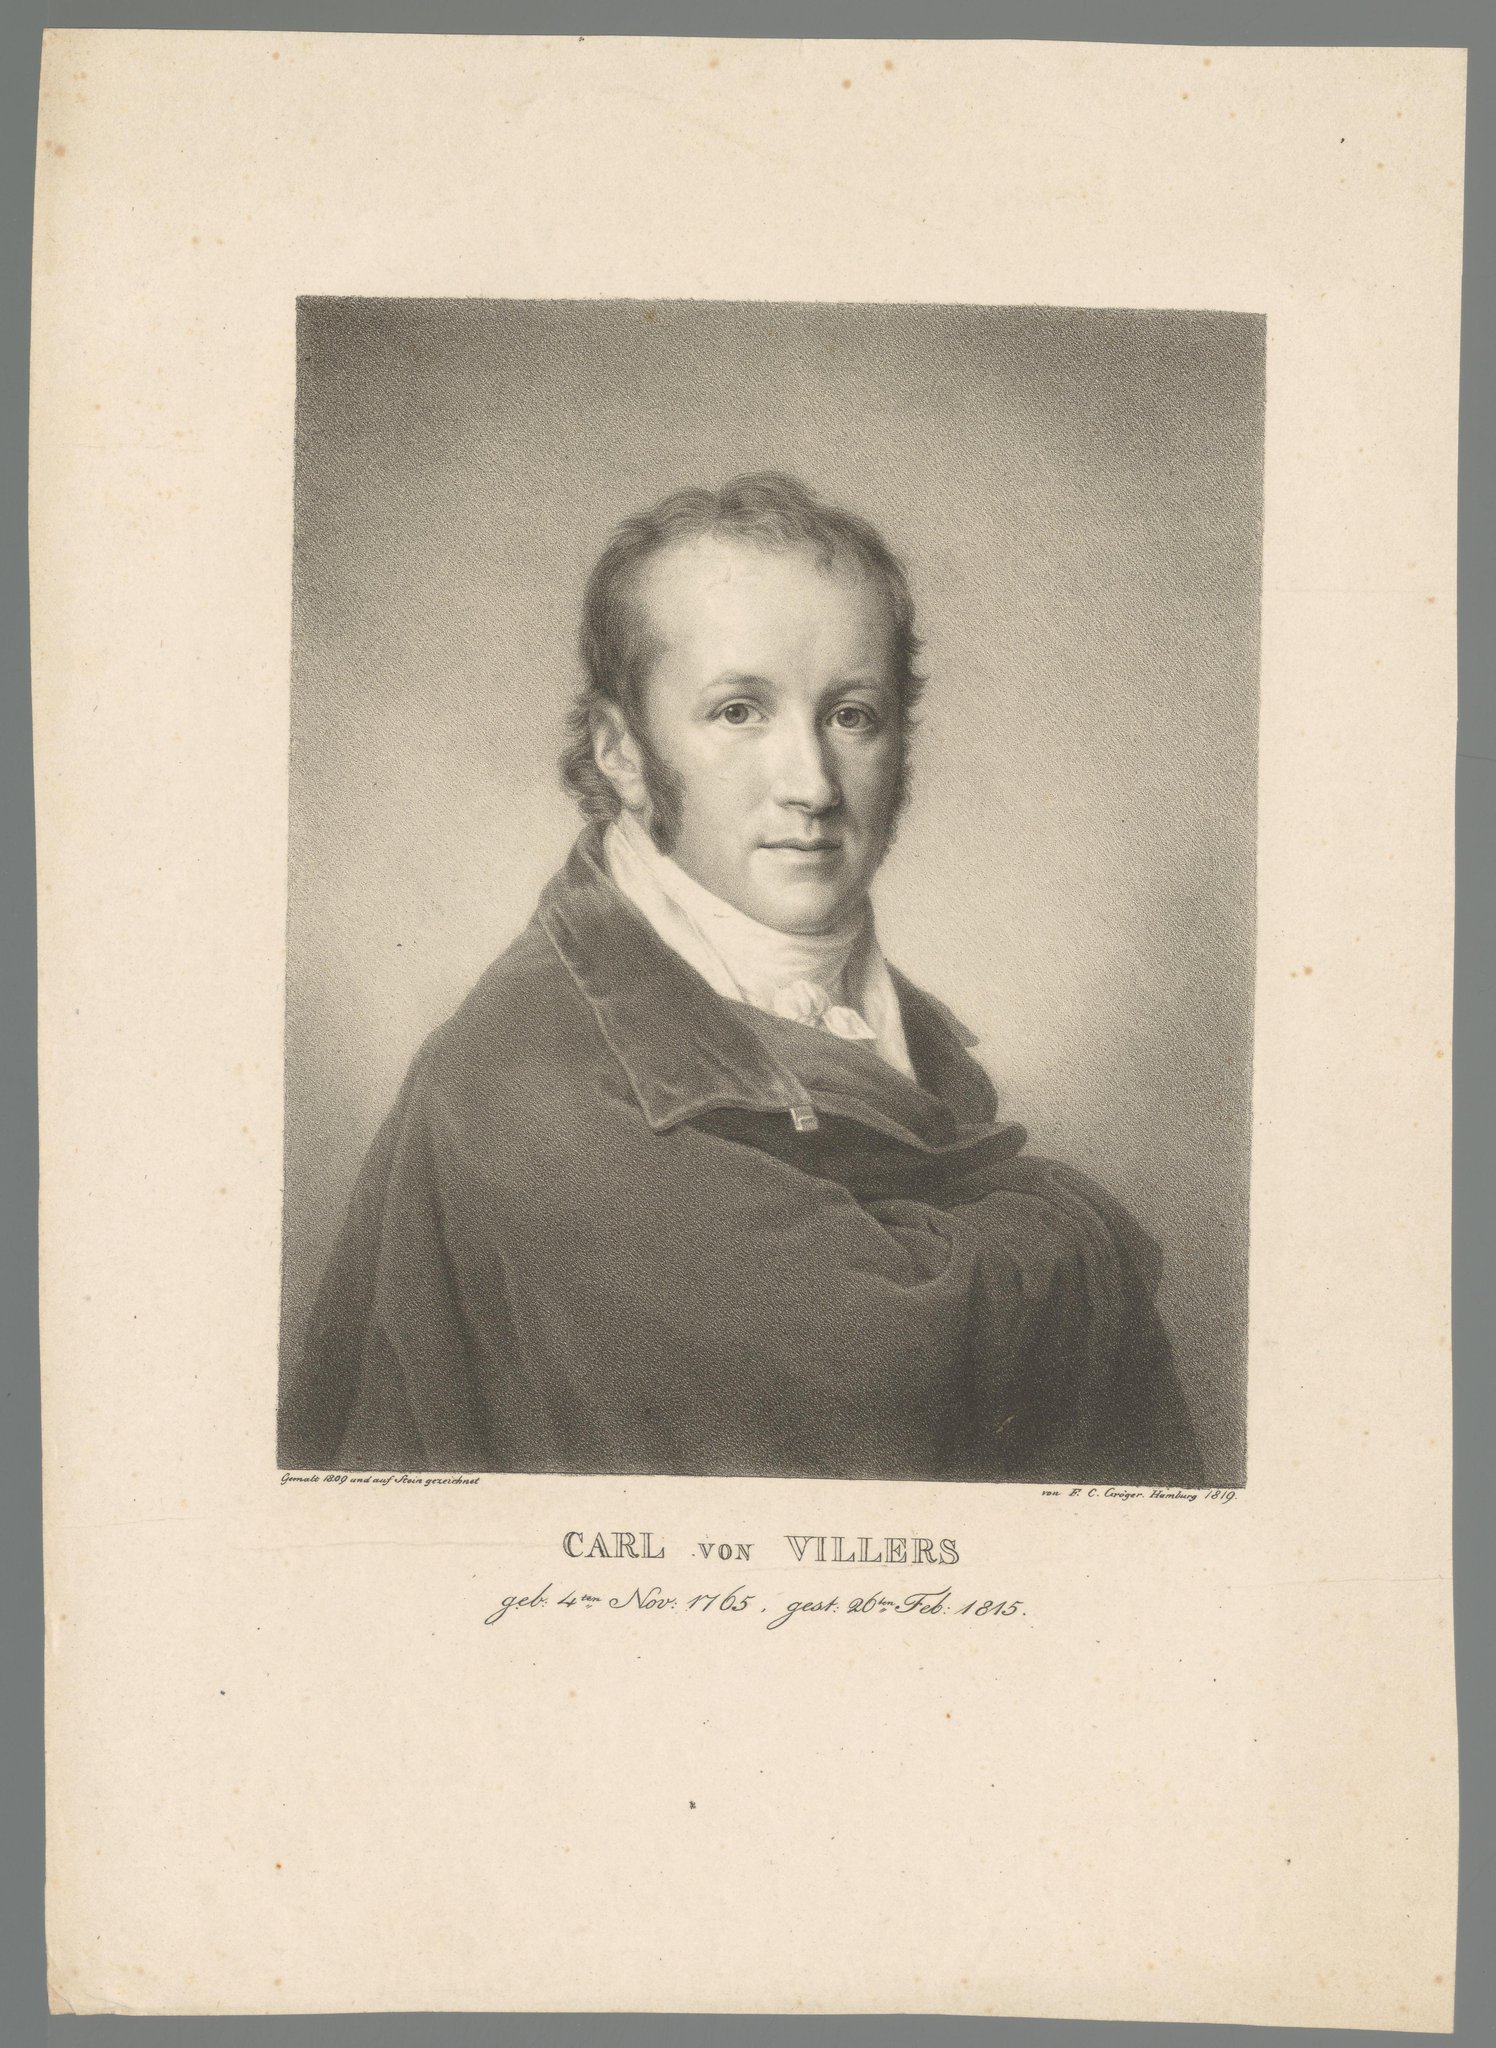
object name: print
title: Portret van Charles de Villers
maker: friedrich carl gröger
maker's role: draughtsman, painter, print maker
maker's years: 1766-1838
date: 1819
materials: paper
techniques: lithograph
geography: hamburg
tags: adult man, historical persons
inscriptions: collector's mark: Lugt 2228